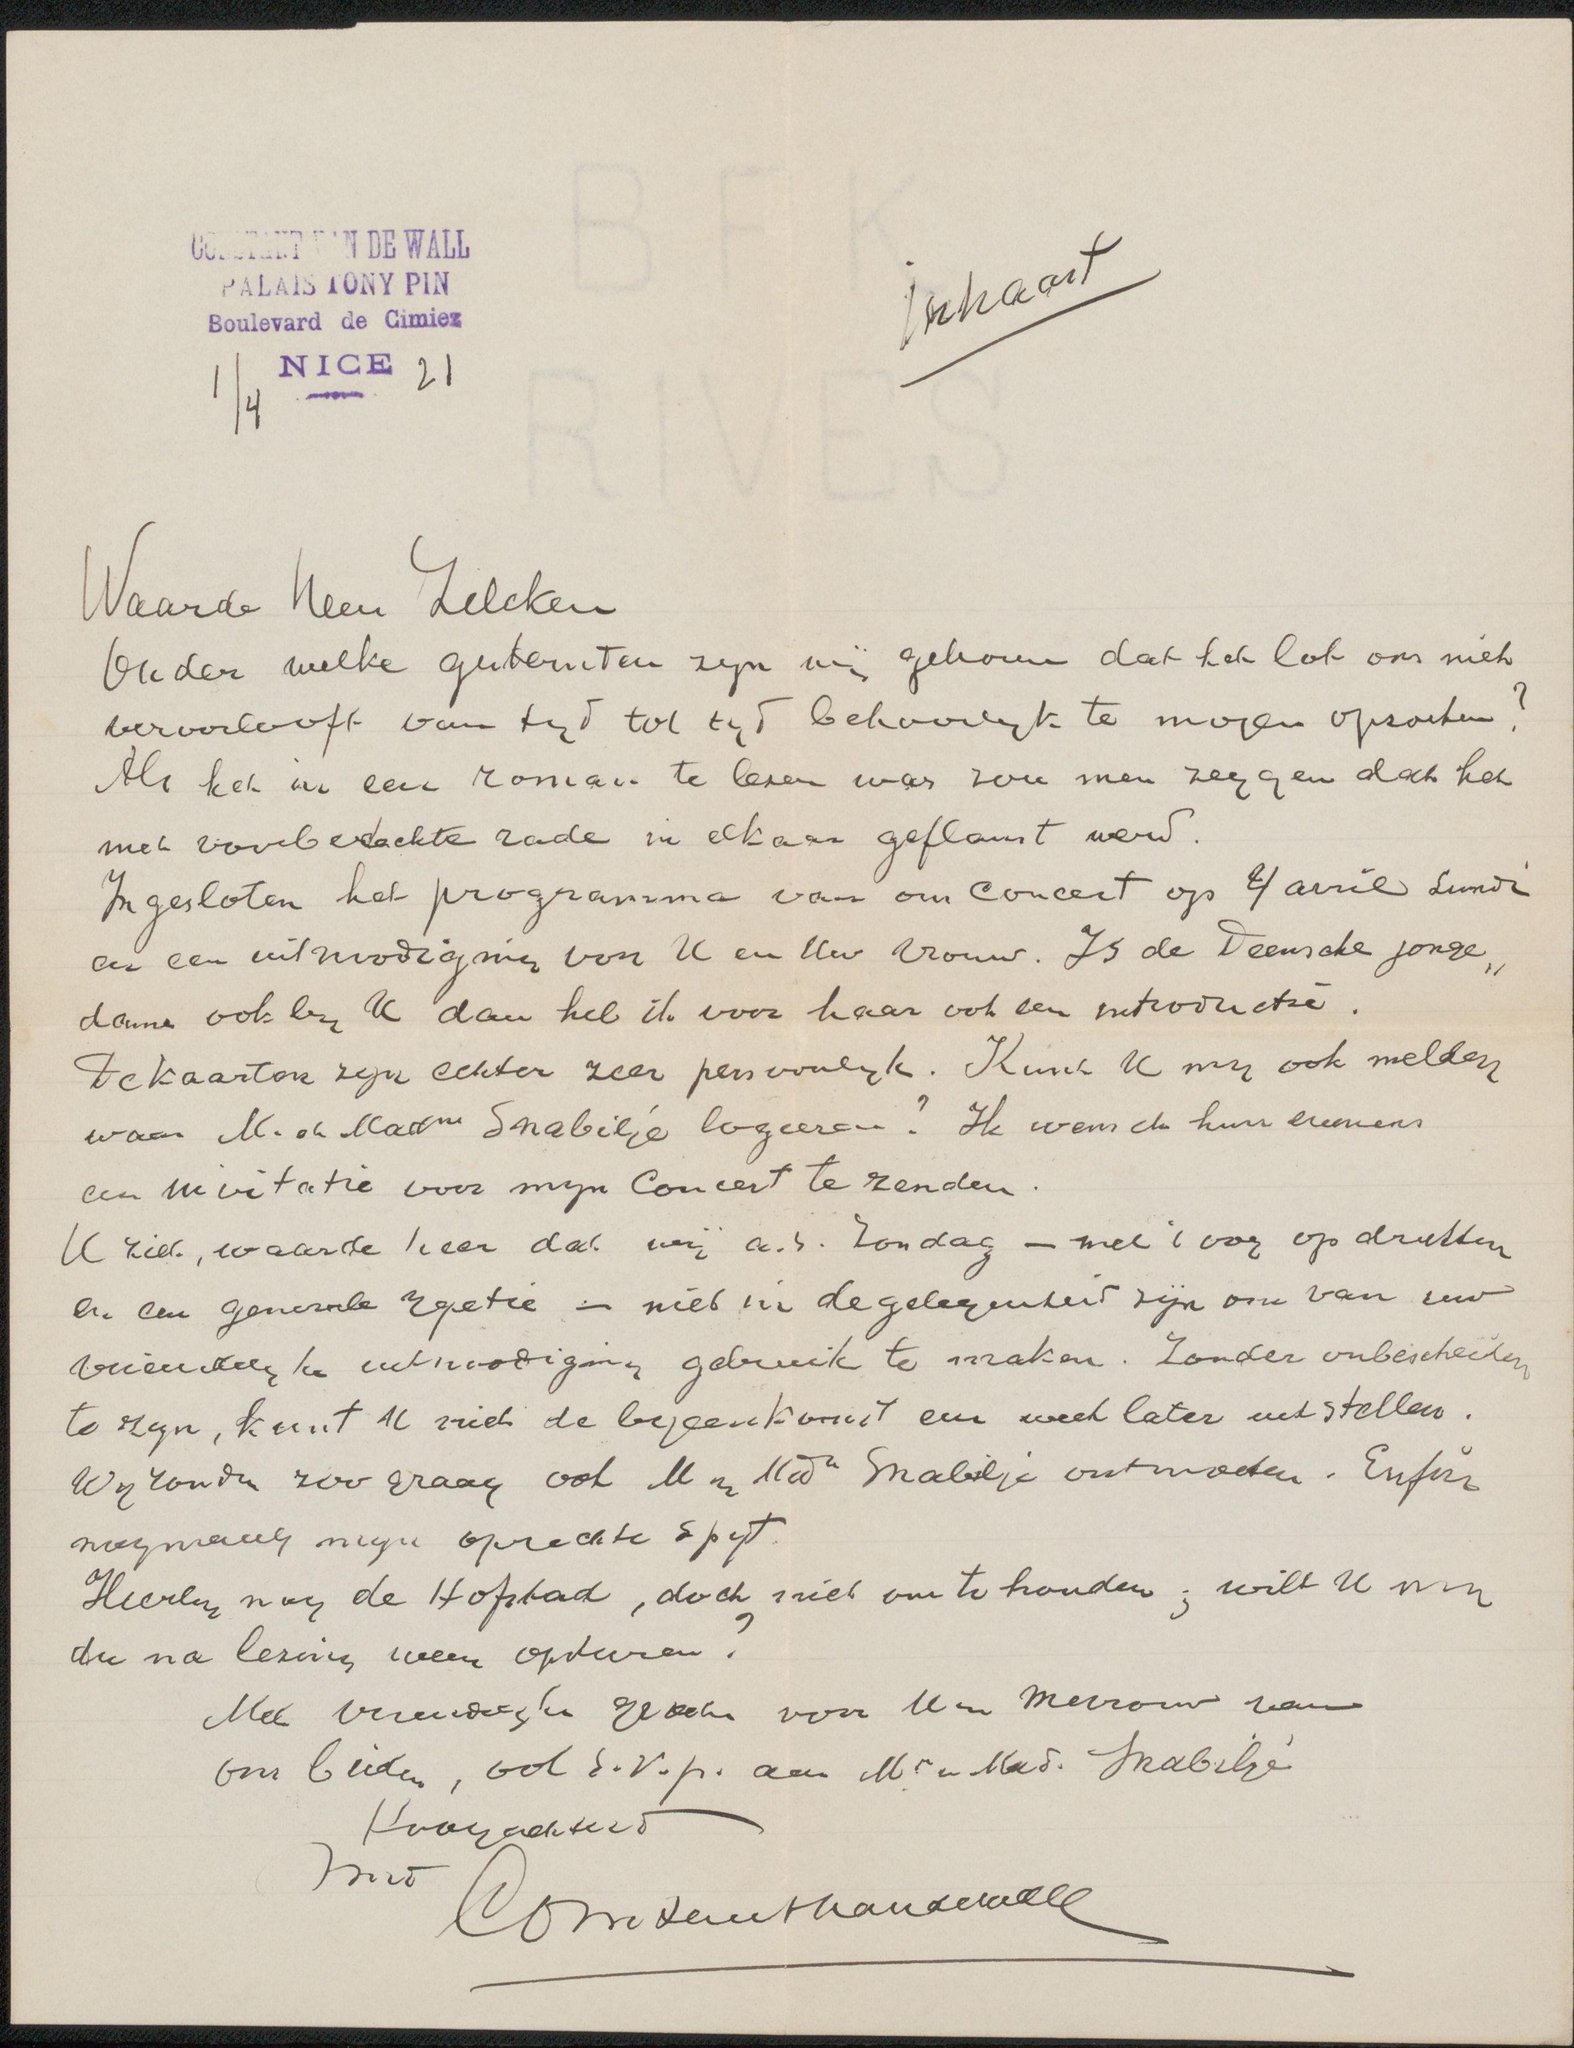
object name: letter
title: Brief aan Philip Zilcken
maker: johan constant arnold van de wall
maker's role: componist, dirigent, docent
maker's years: 1871-1945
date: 1921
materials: ink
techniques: pen, writing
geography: nice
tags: charles snabilié, mevrouw snabilié, the hague, painter, philip zilcken, music, printed matter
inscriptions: watermark, address: ‘CONSTANT VAN DE WALL/ PALAIS TONY PIN/ Boulevard de Cimiez/ NICE’, collector's mark: ‘RPK’